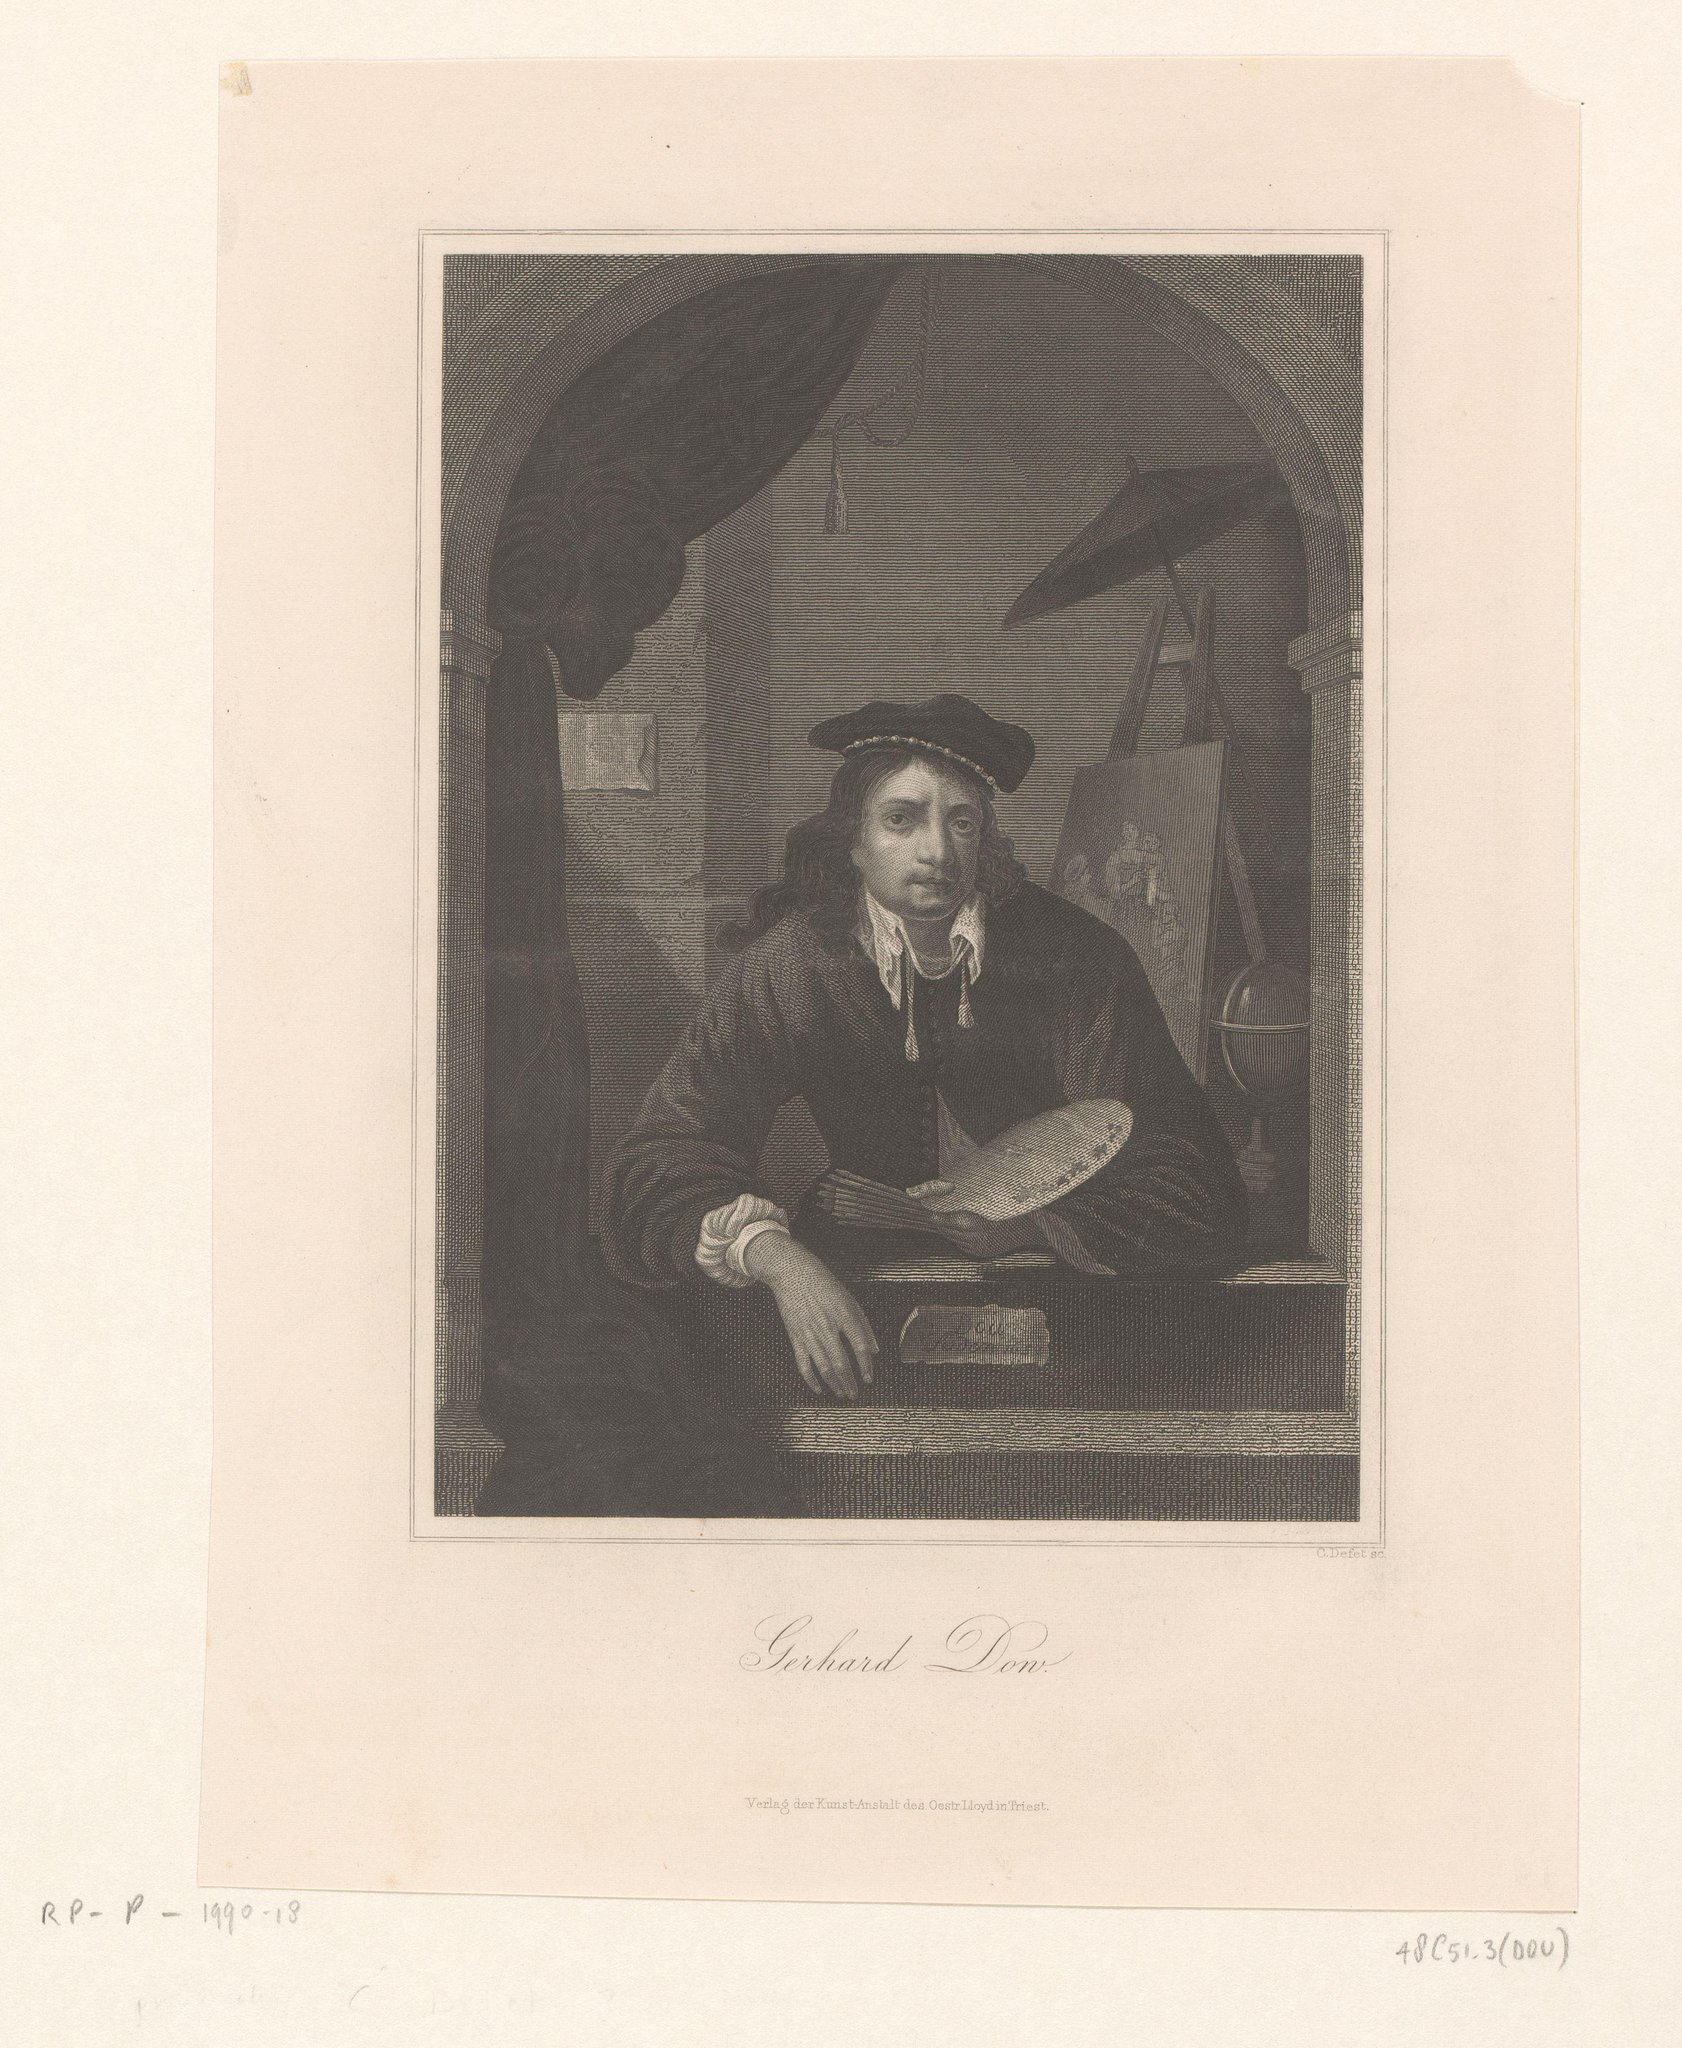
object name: print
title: Portret van Gerard Dou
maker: c. defet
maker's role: print maker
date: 1849-1870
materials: paper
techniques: etching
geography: trieste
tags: leiden, painter, draughtsman, gerard dou, historical persons, portrait, self-portrait of painter, palette, picture, painting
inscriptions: collector's mark: Lugt 2228